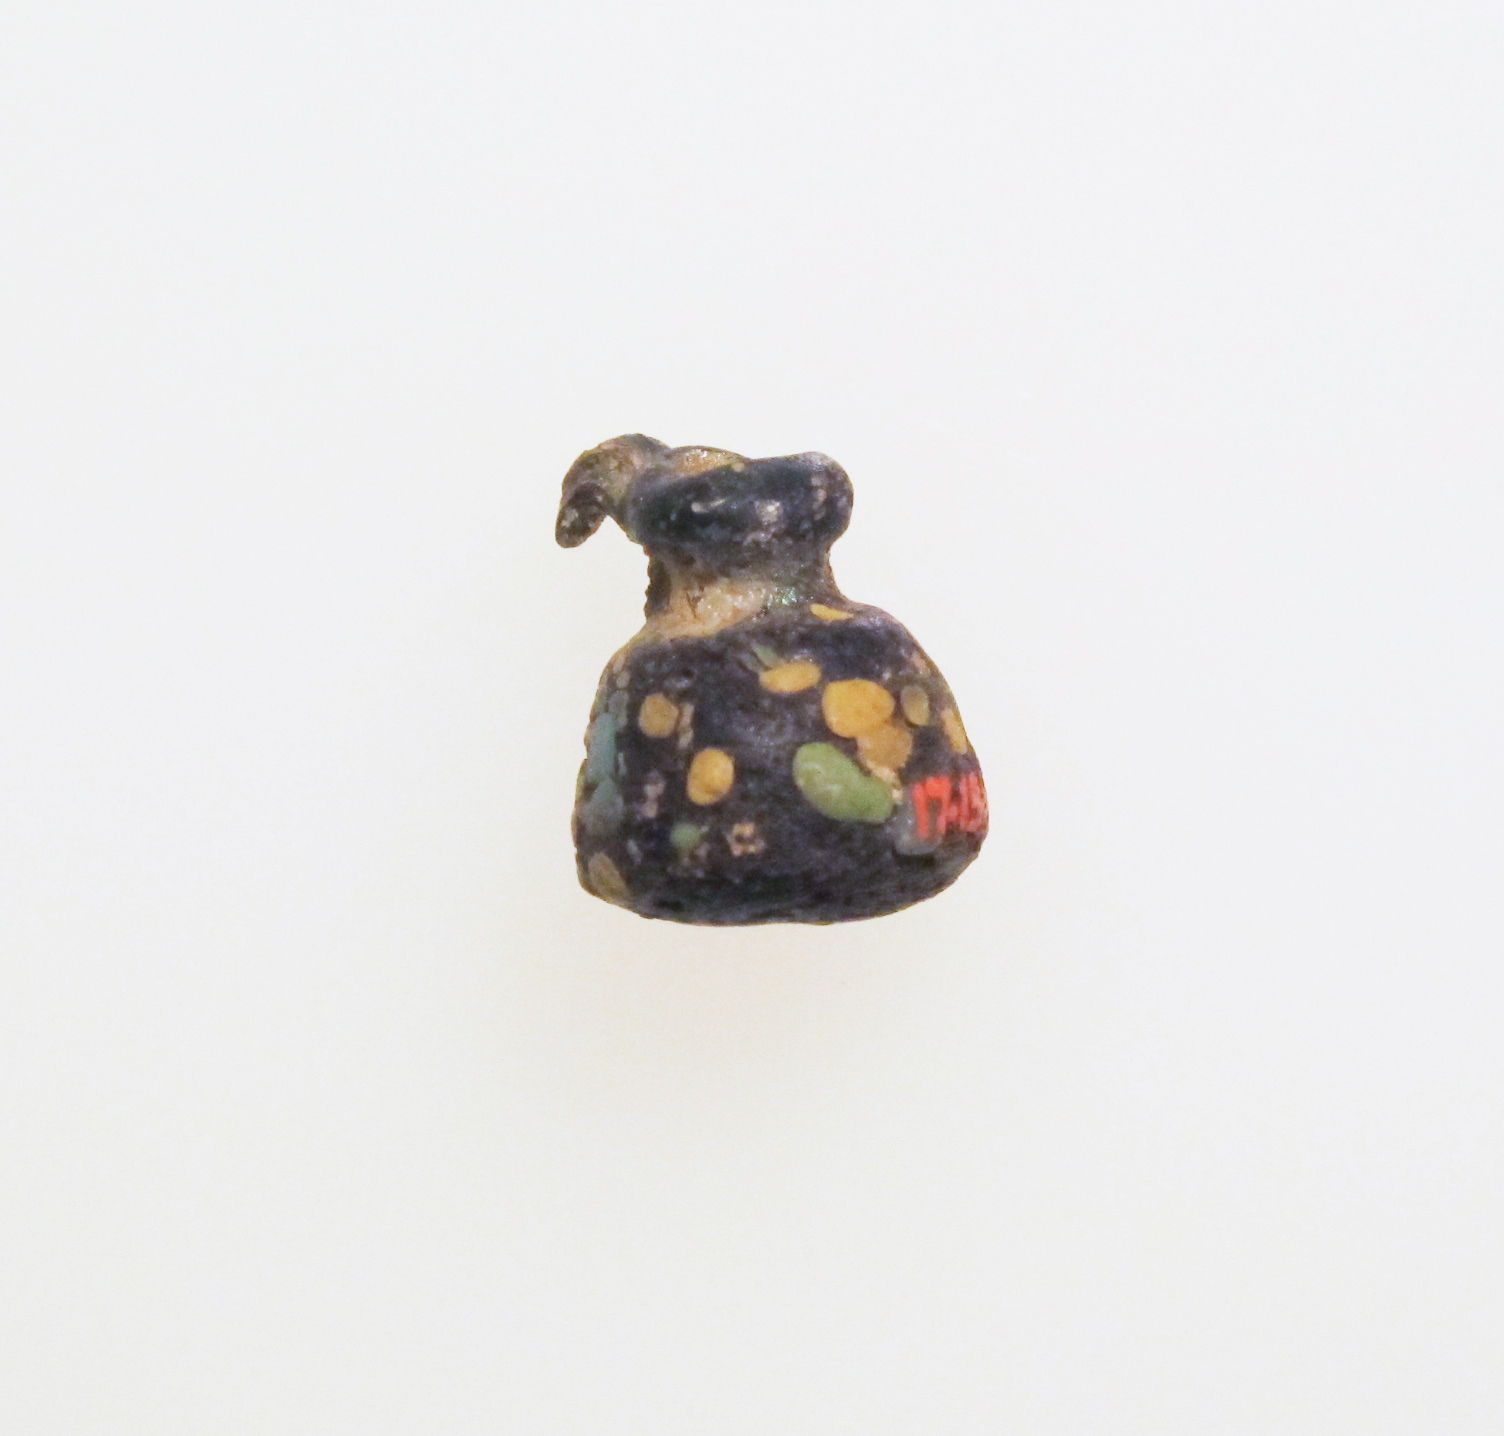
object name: pendant in the form of a vase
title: Glass pendant shaped like a jug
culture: roman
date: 201-400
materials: glass